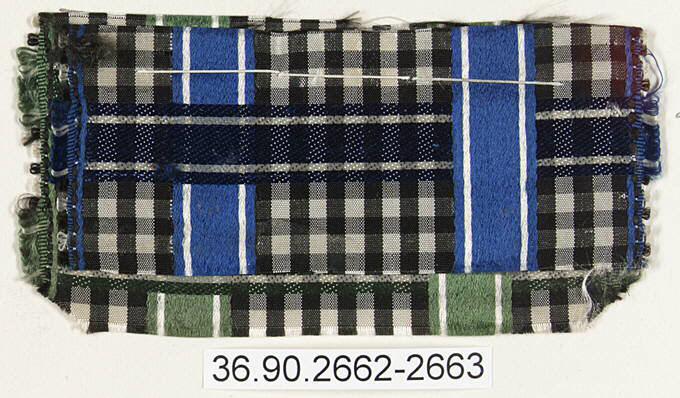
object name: ribbon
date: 1801-1900